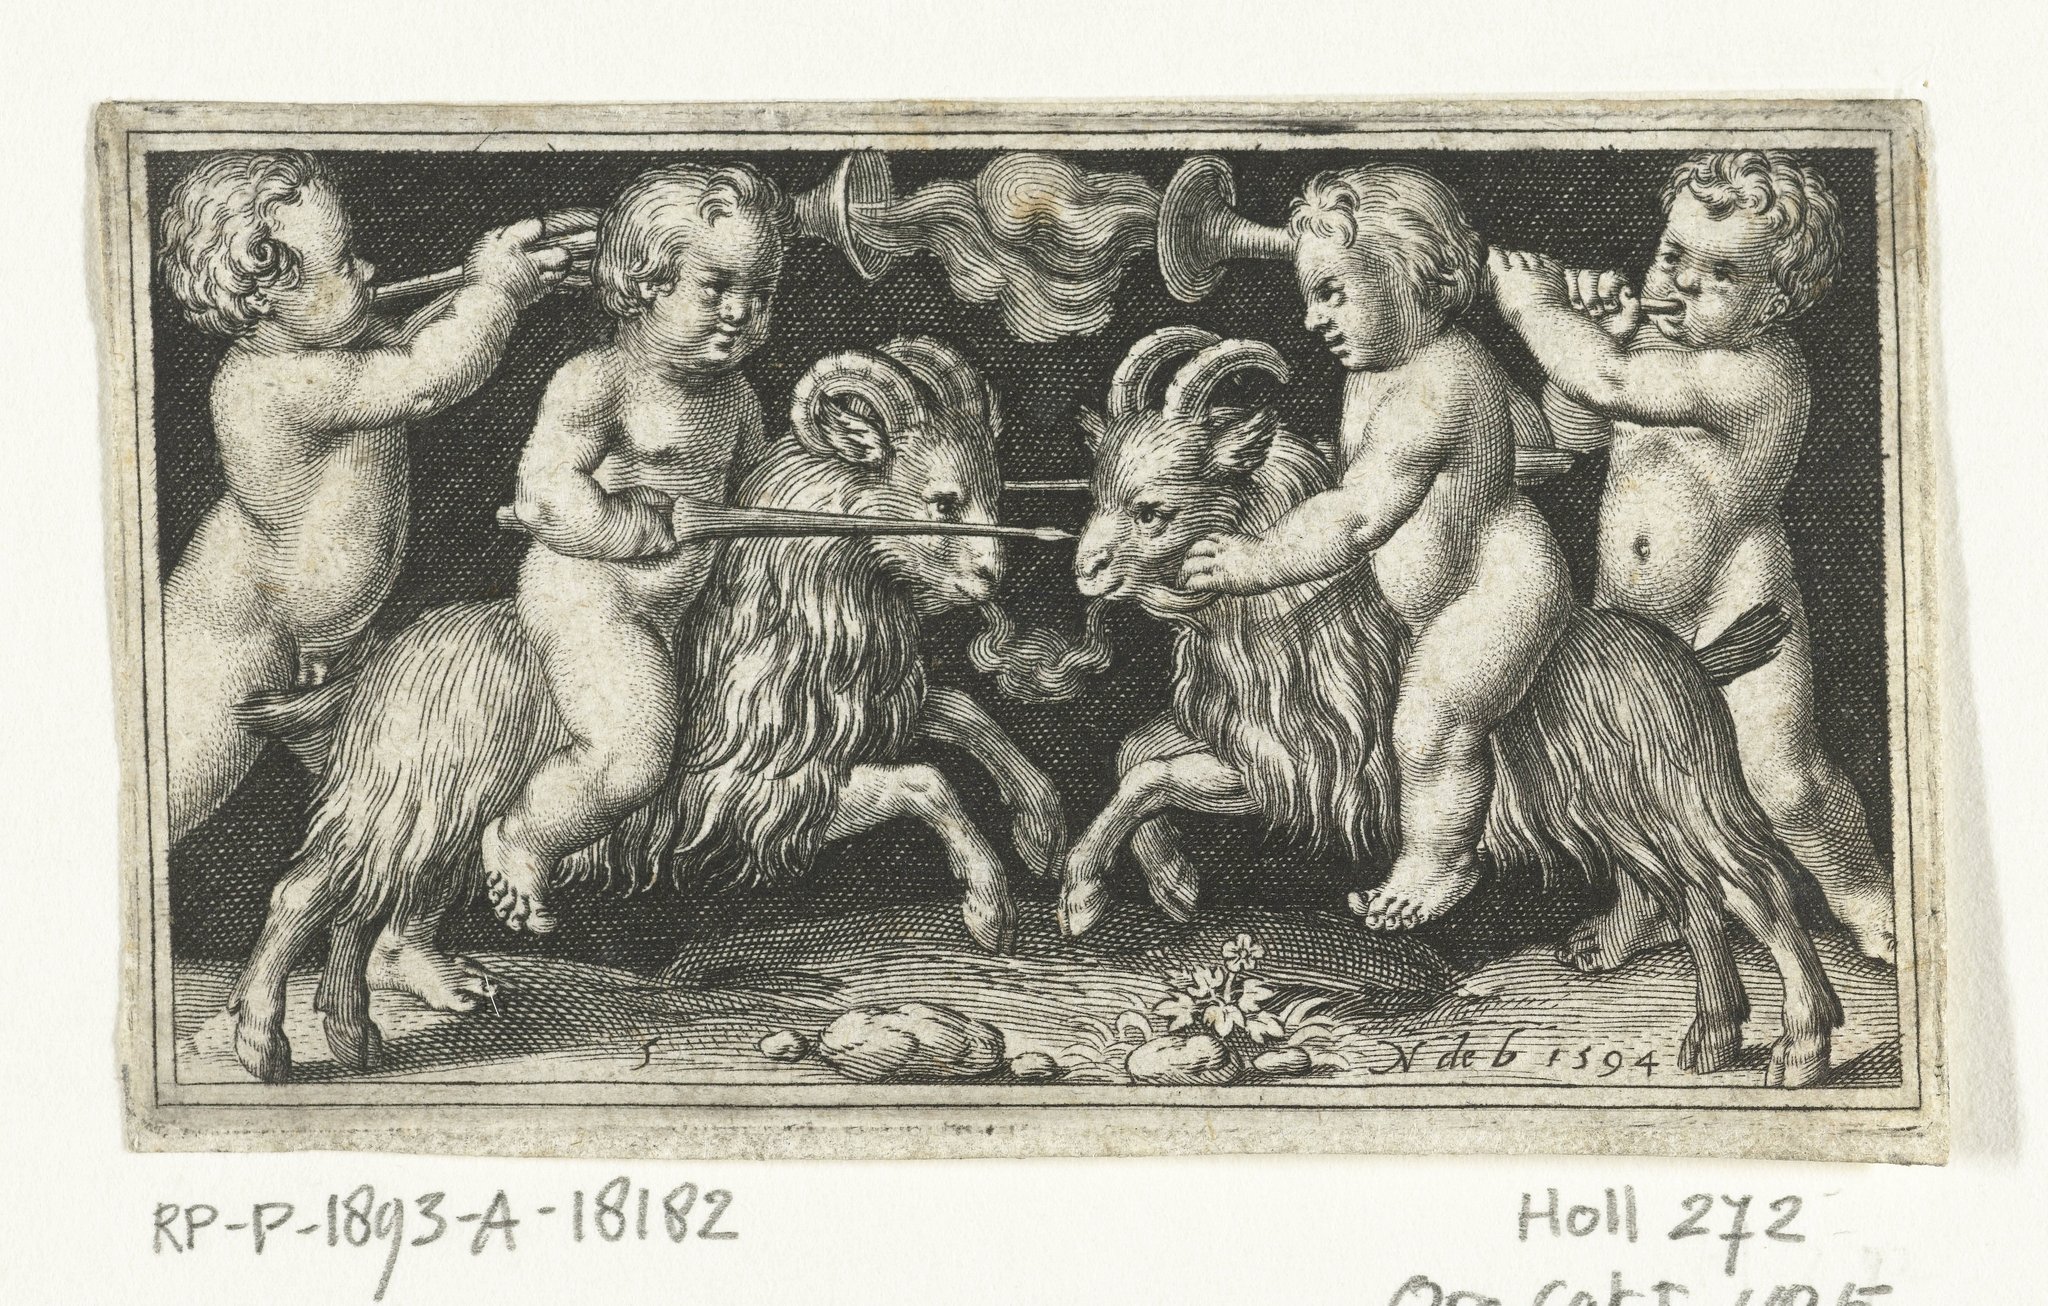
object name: print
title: Twee liggende engeltjes leunen op schedel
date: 1594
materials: paper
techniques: engraving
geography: netherlands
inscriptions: collector's mark: Lugt 2228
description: Prent uit serie van zes prenten met Friezen met kinderen, engeltjes en dieren. Hollstein beschrijft deze serie twee keer onder de nrs. 142-147 en 268-273.